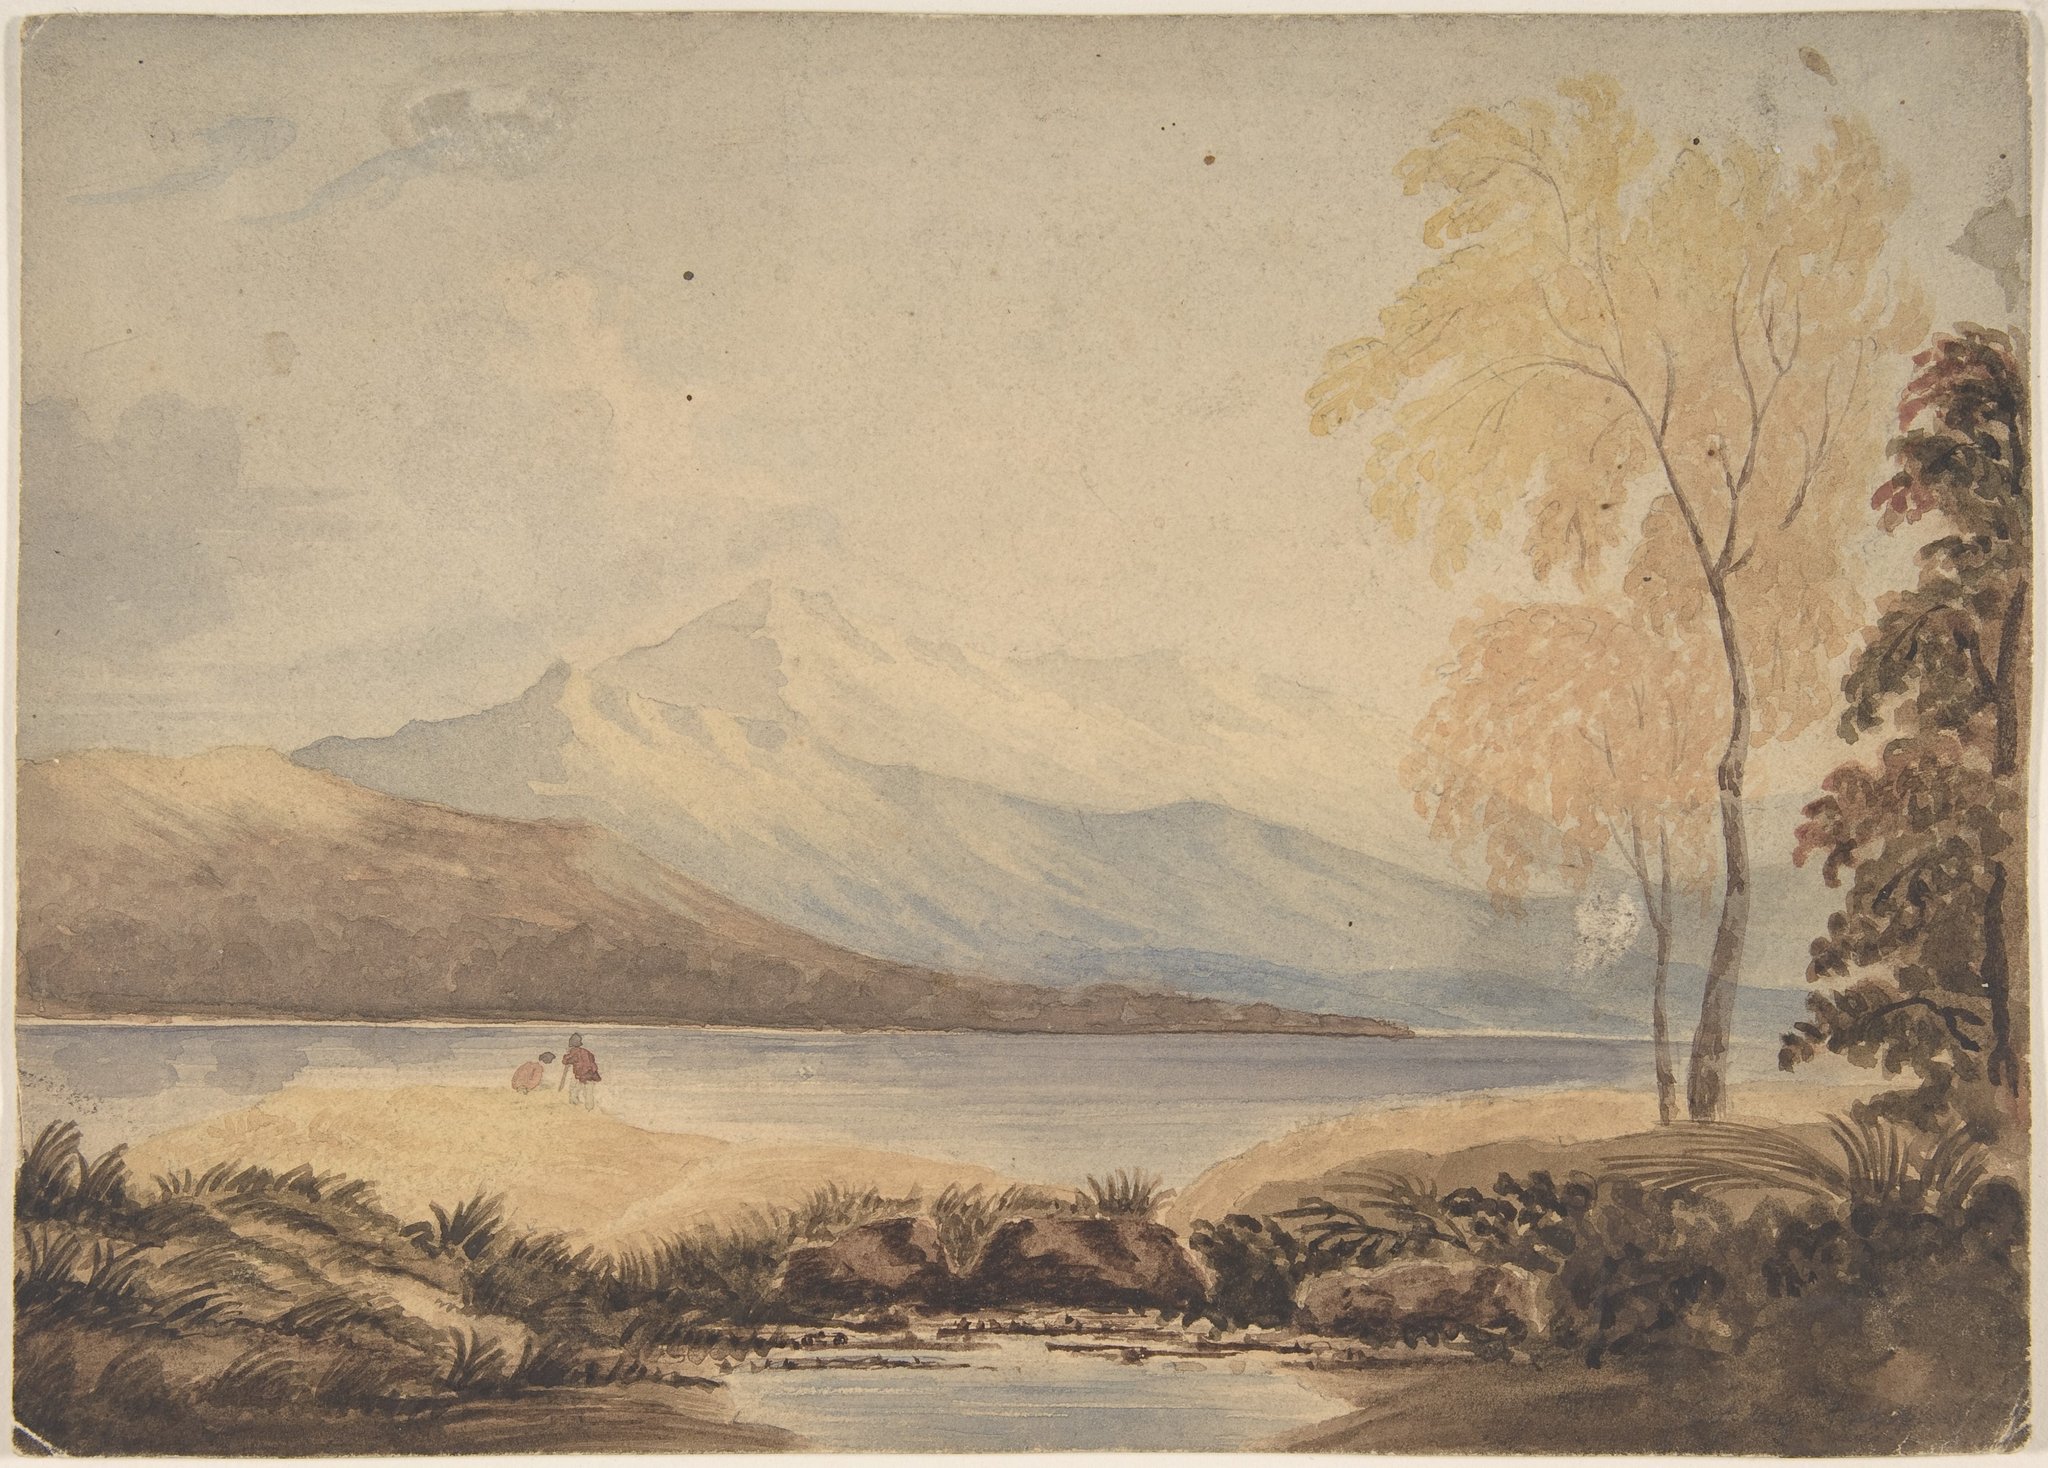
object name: drawing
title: Lakeland Landscape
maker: copley fielding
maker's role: artist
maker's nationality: british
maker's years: 1787-1855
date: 1801-1833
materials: graphite, watercolor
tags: lakes,mountains,landscapes,trees